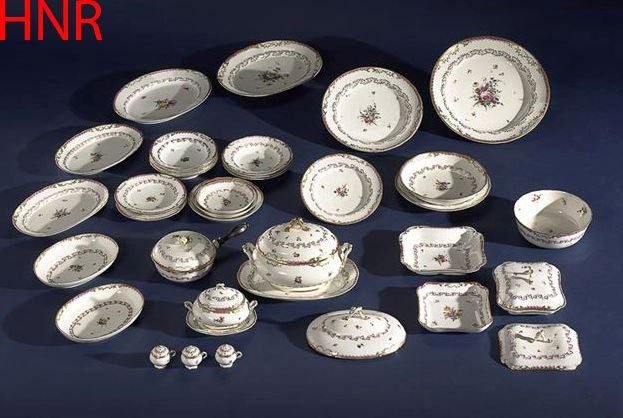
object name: plate dish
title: Bord, plat model, behorend bij een servies met geslingerd lintmotief met bladertakken, bloemboeketten en gestrooide bloemtakken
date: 1780-1820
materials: porcelain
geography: amsterdam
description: Bord, plat model, behorend bij een servies van porselein met geslingerd lintmotief in paars en goud met groene bladertakken, bloemboeketten en gestrooide bloemtakken. Randen lichtgegolfd met decoratie in goud met paars bladmotief waartussen groen gekruist bladmotief. Gemerkt: M.O.L. of AMSTEL.